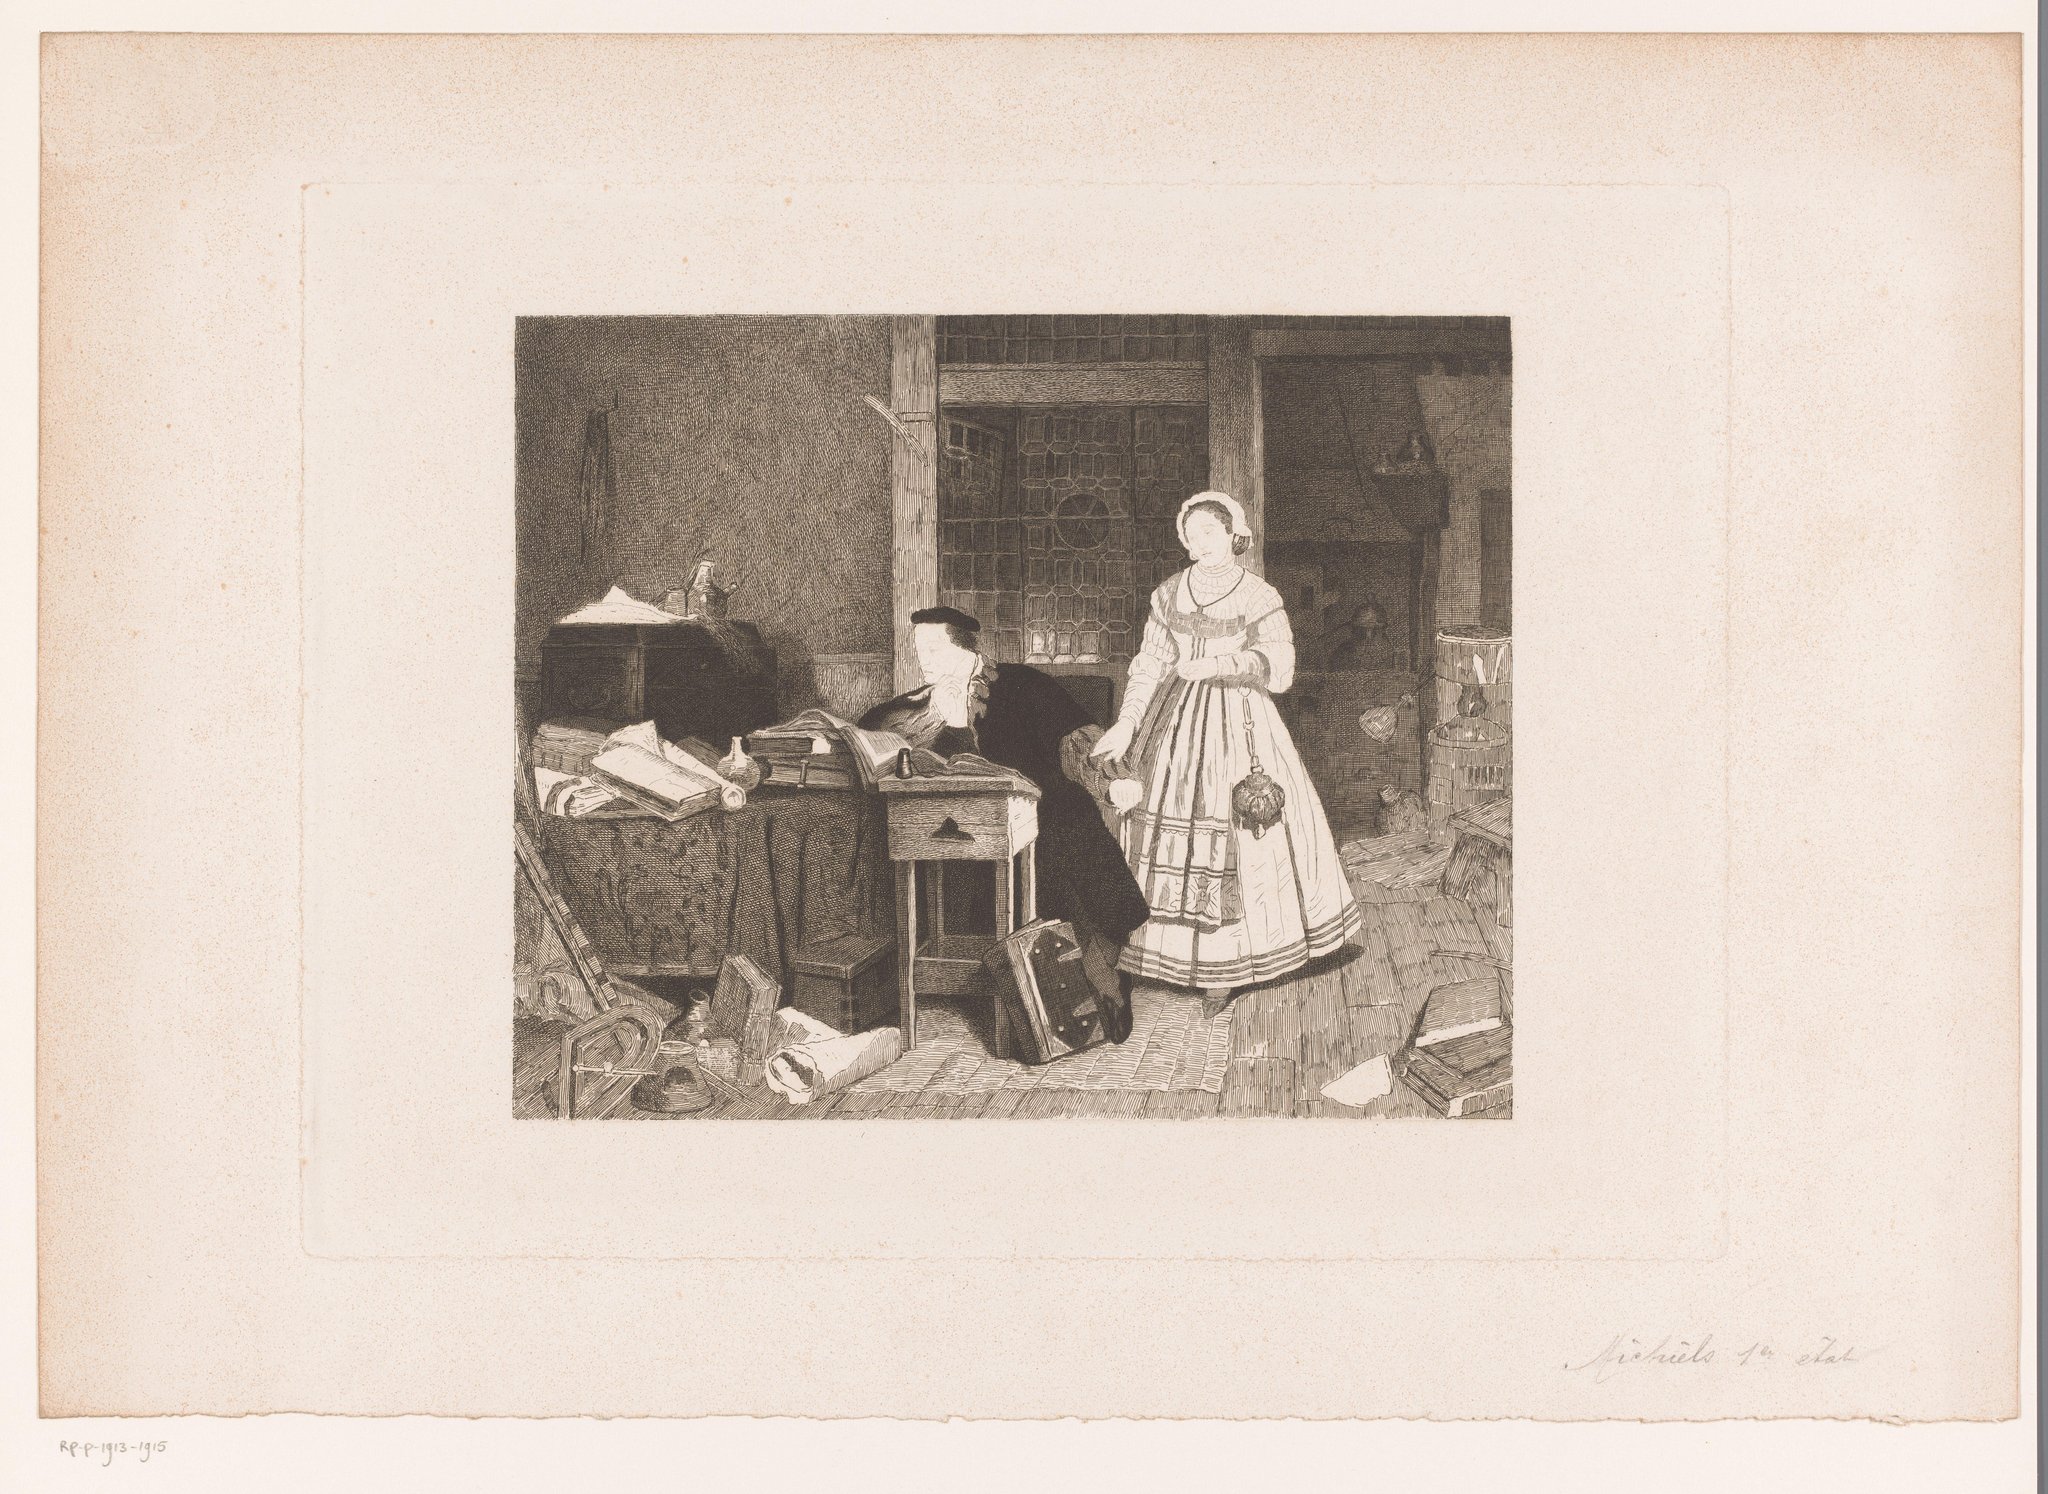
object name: print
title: Interieur met een vrouw staand naast een lezende man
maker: jean baptiste pierre michiels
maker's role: print maker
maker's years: 1821-1890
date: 1831-1890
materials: paper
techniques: etching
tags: reading, book, interior ~ representation of a building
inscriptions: collector's mark: Lugt 2228, inscription: ‘1e etat’